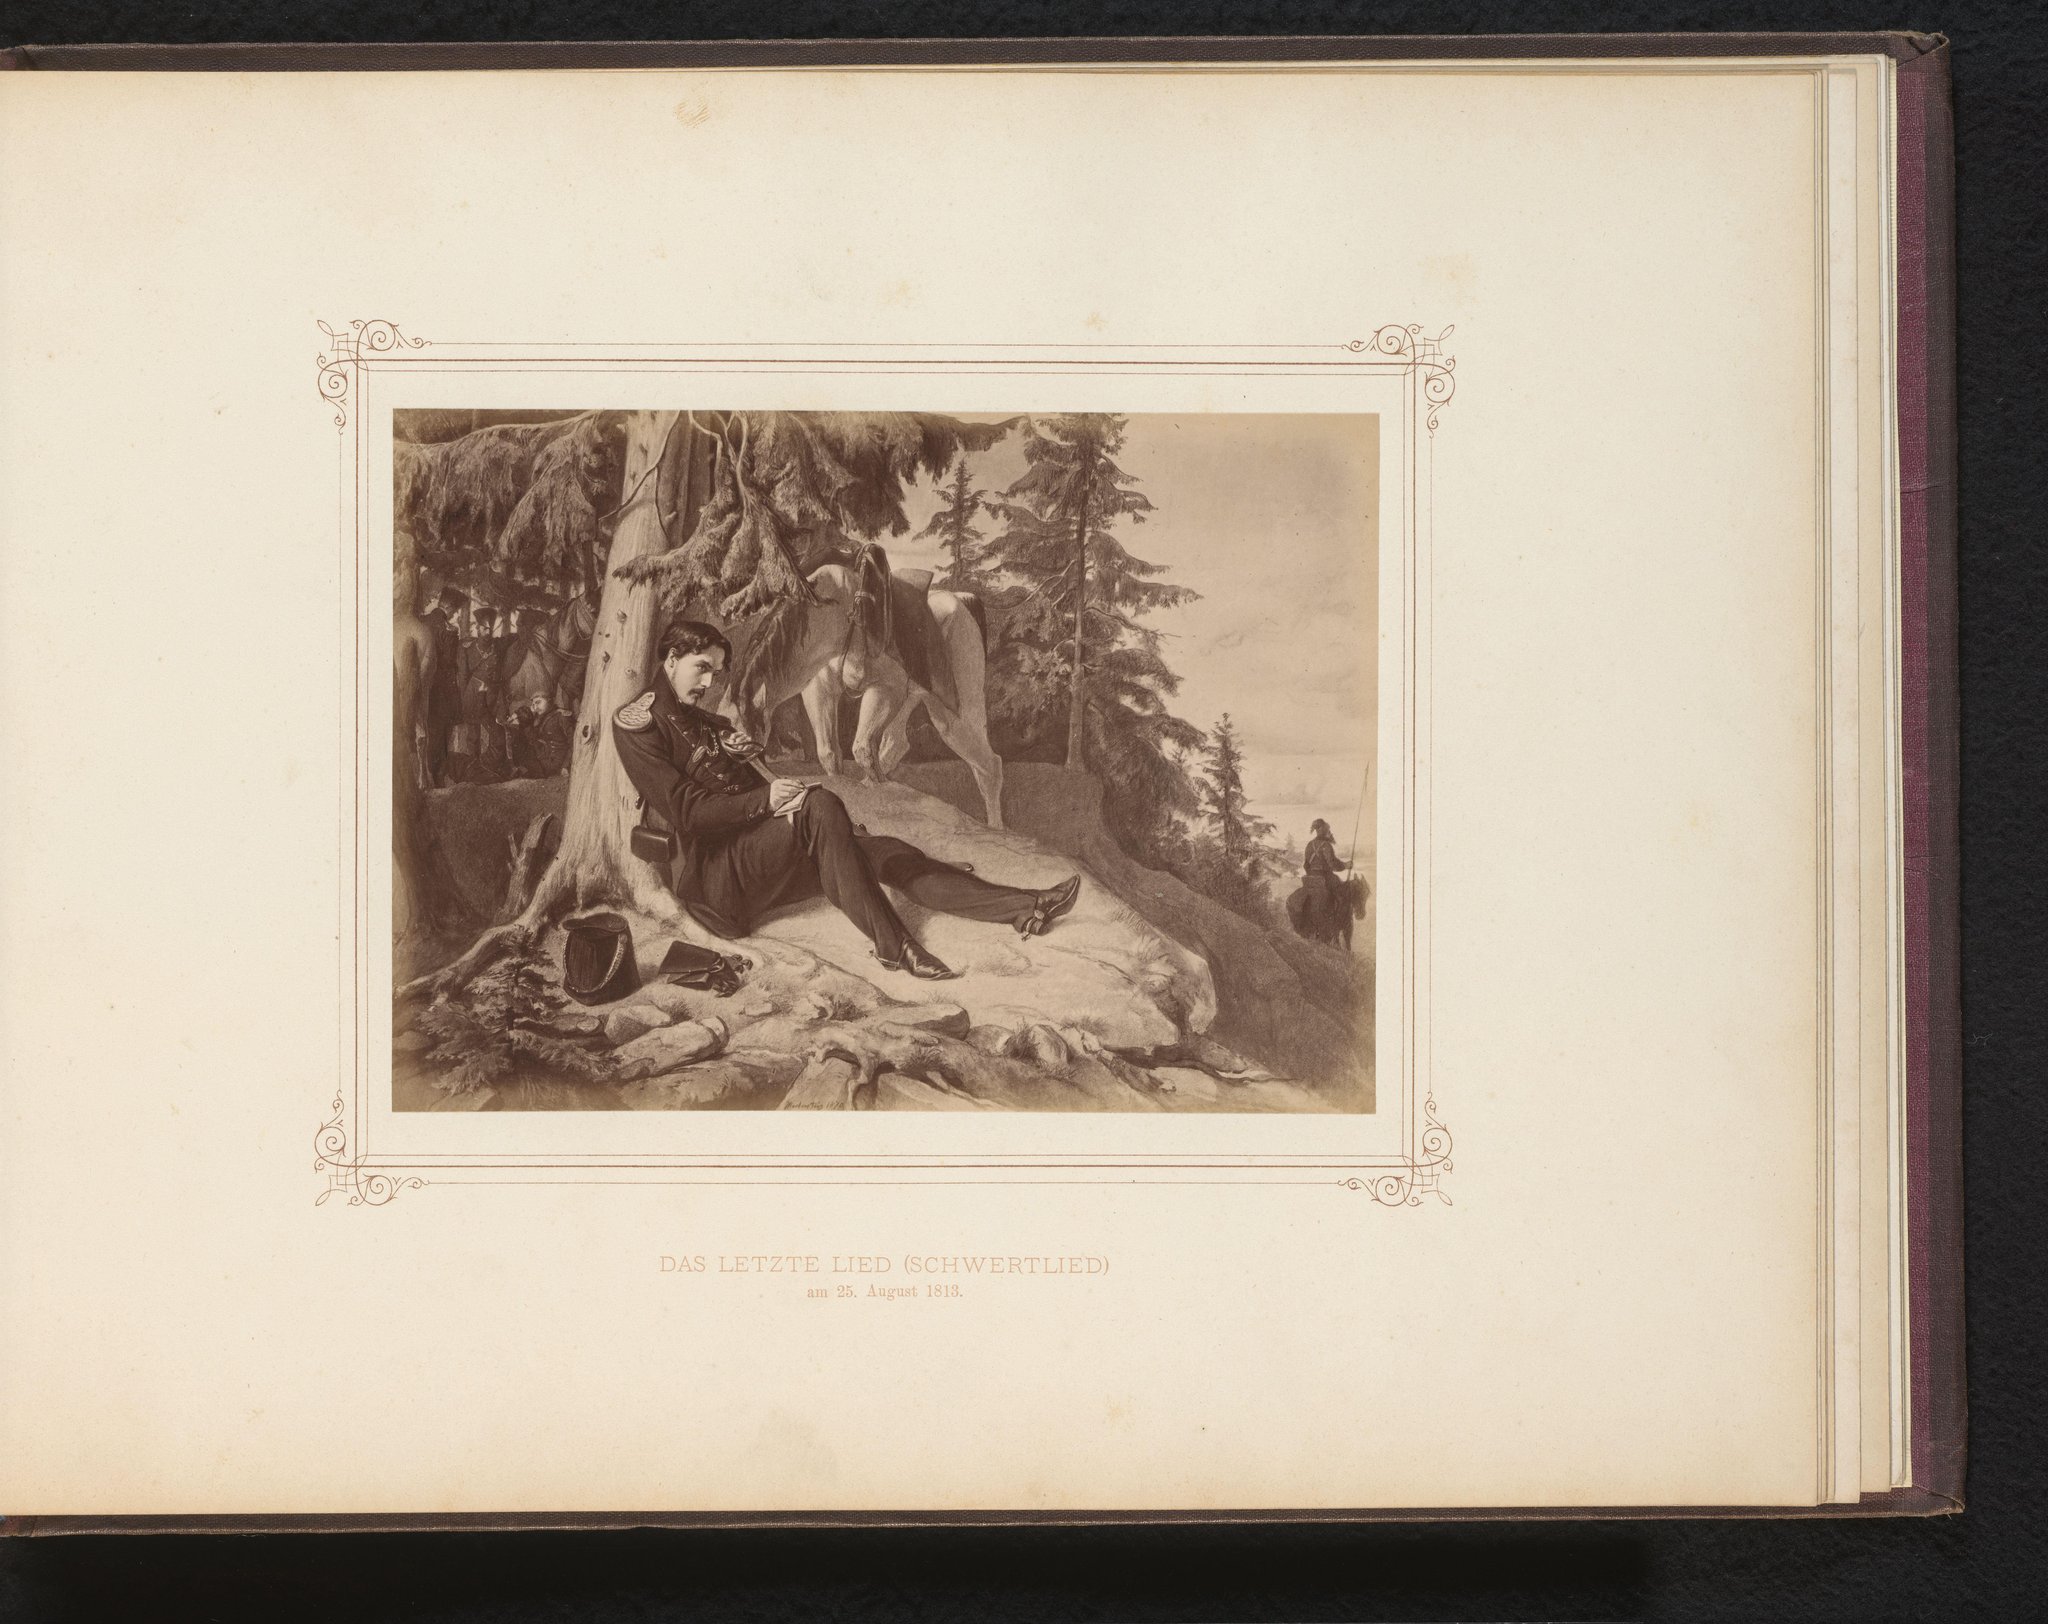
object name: page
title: Fotoreproductie van een schilderij van een rustende soldaat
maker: Anonymous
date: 1860-1875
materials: paper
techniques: albumen print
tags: the soldier; the soldier's life, picture, painting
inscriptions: inscription: ‘DAS LETZTE LIED (SCHWERTLIED)/ am 25. August 1813.’